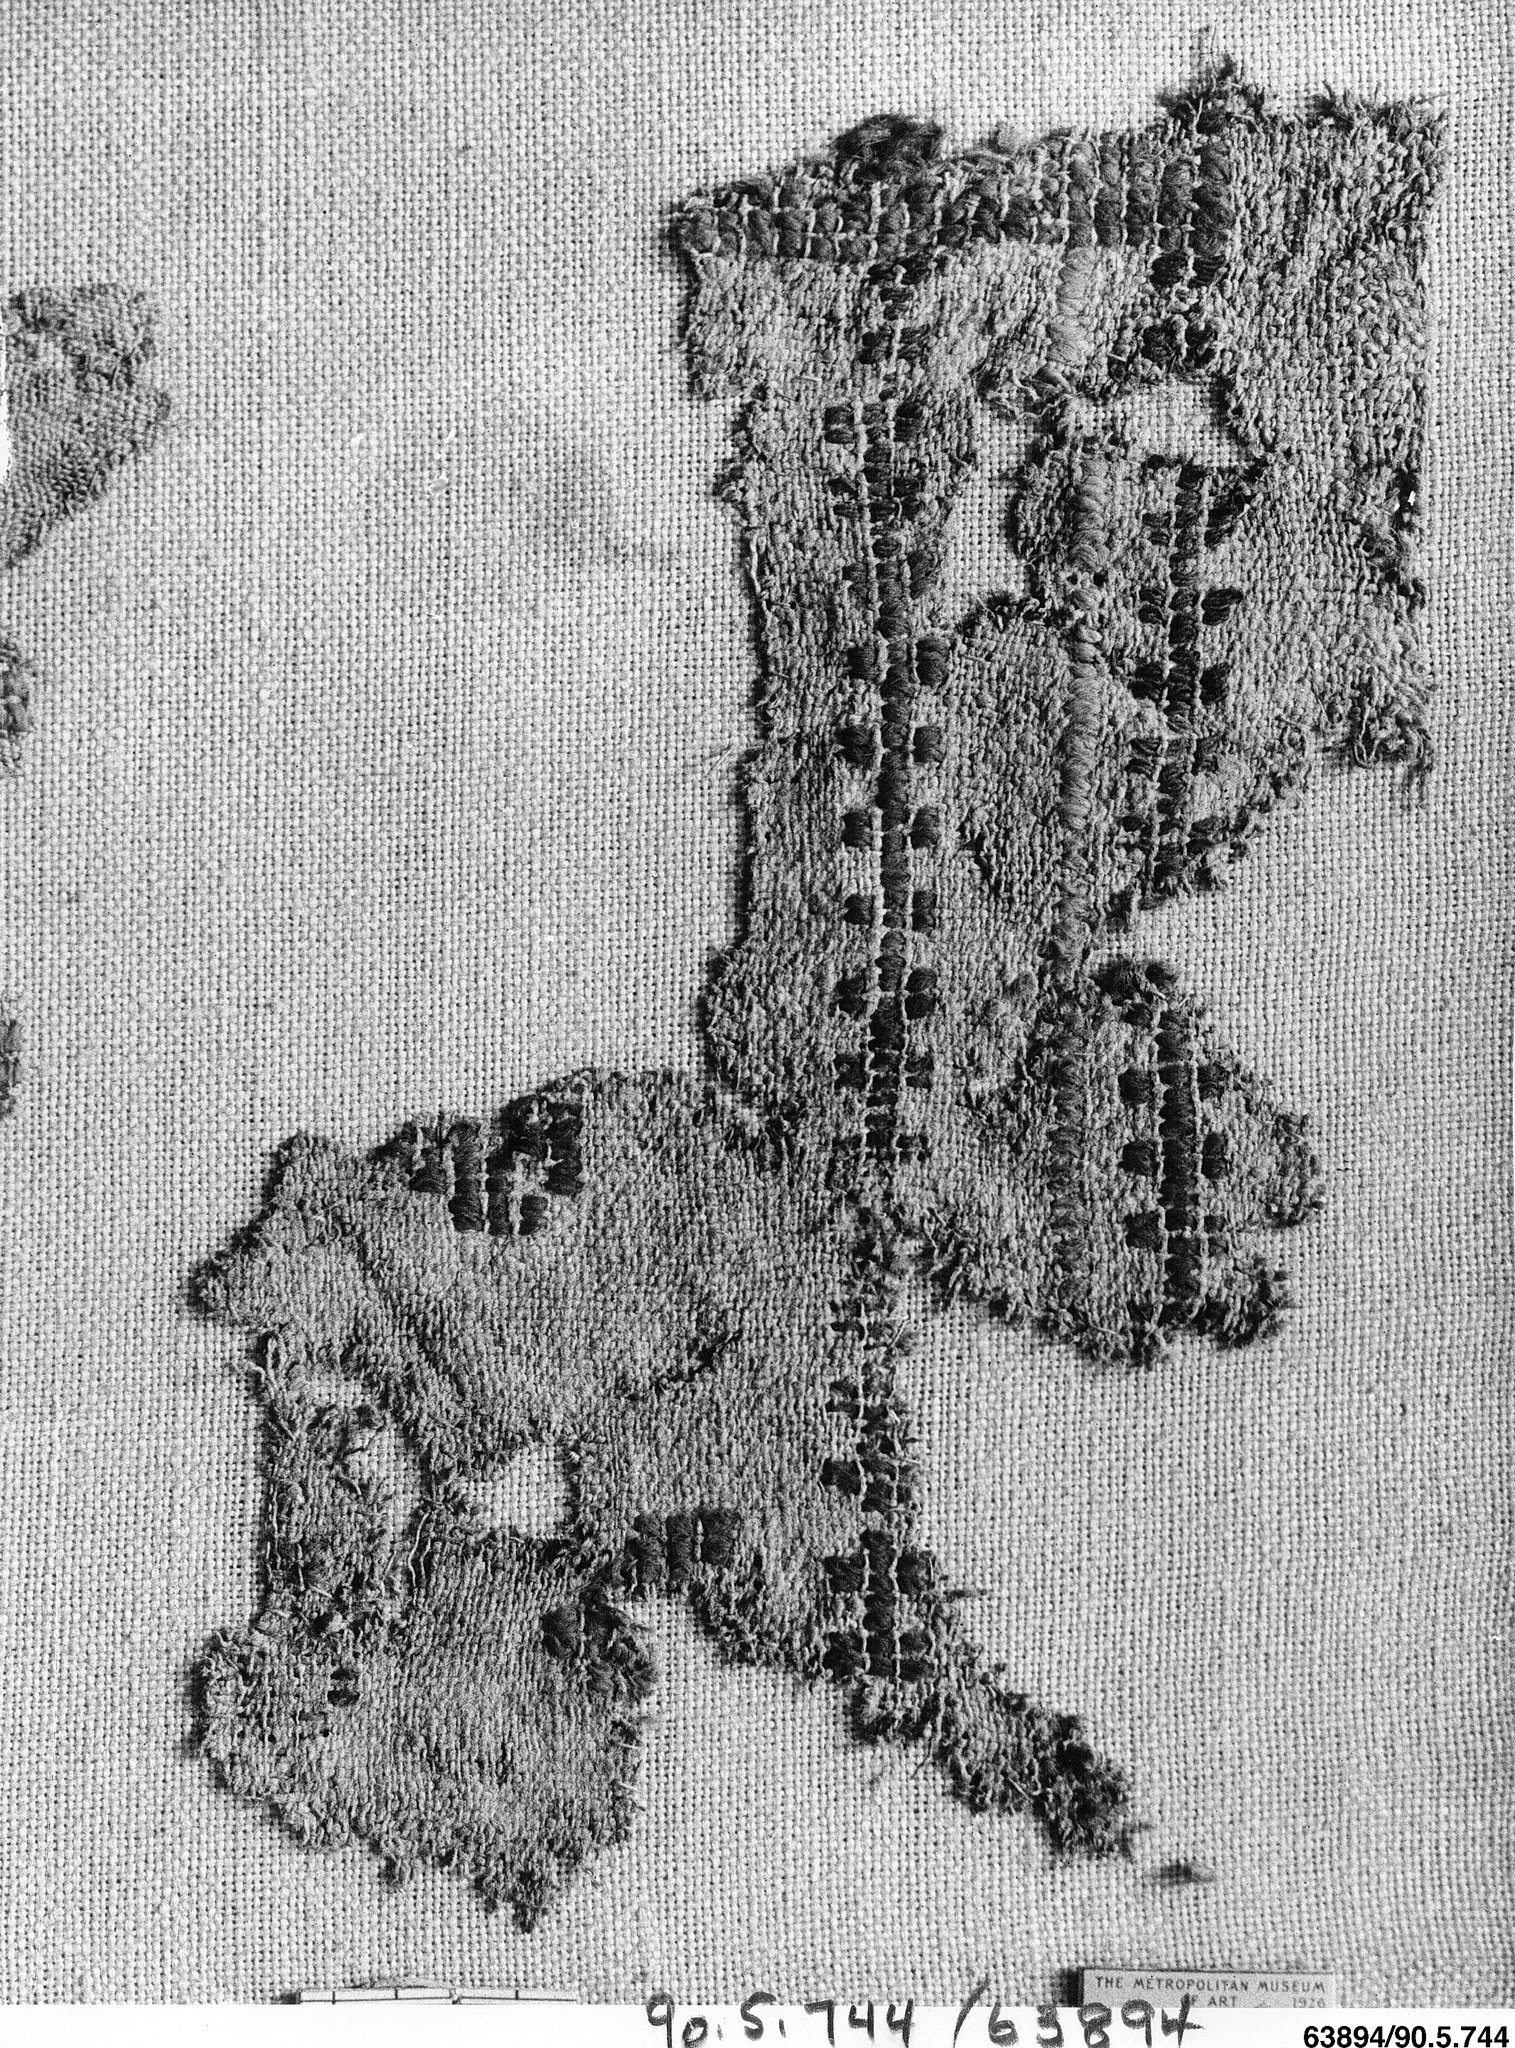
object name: textile fragment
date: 401-600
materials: linen, wool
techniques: brocade, weave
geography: egypt